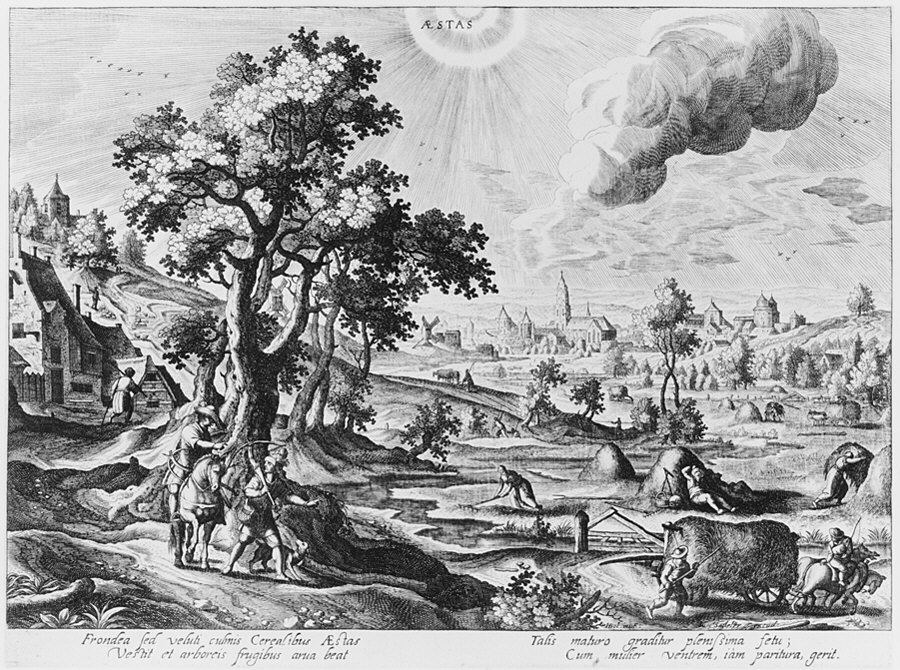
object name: print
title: Four Landscapes with the Four Seasons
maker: hendrick van schoel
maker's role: artist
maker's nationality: dutch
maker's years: 1500-1600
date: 1501-1600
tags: human figures,houses,sun,landscapes,trees